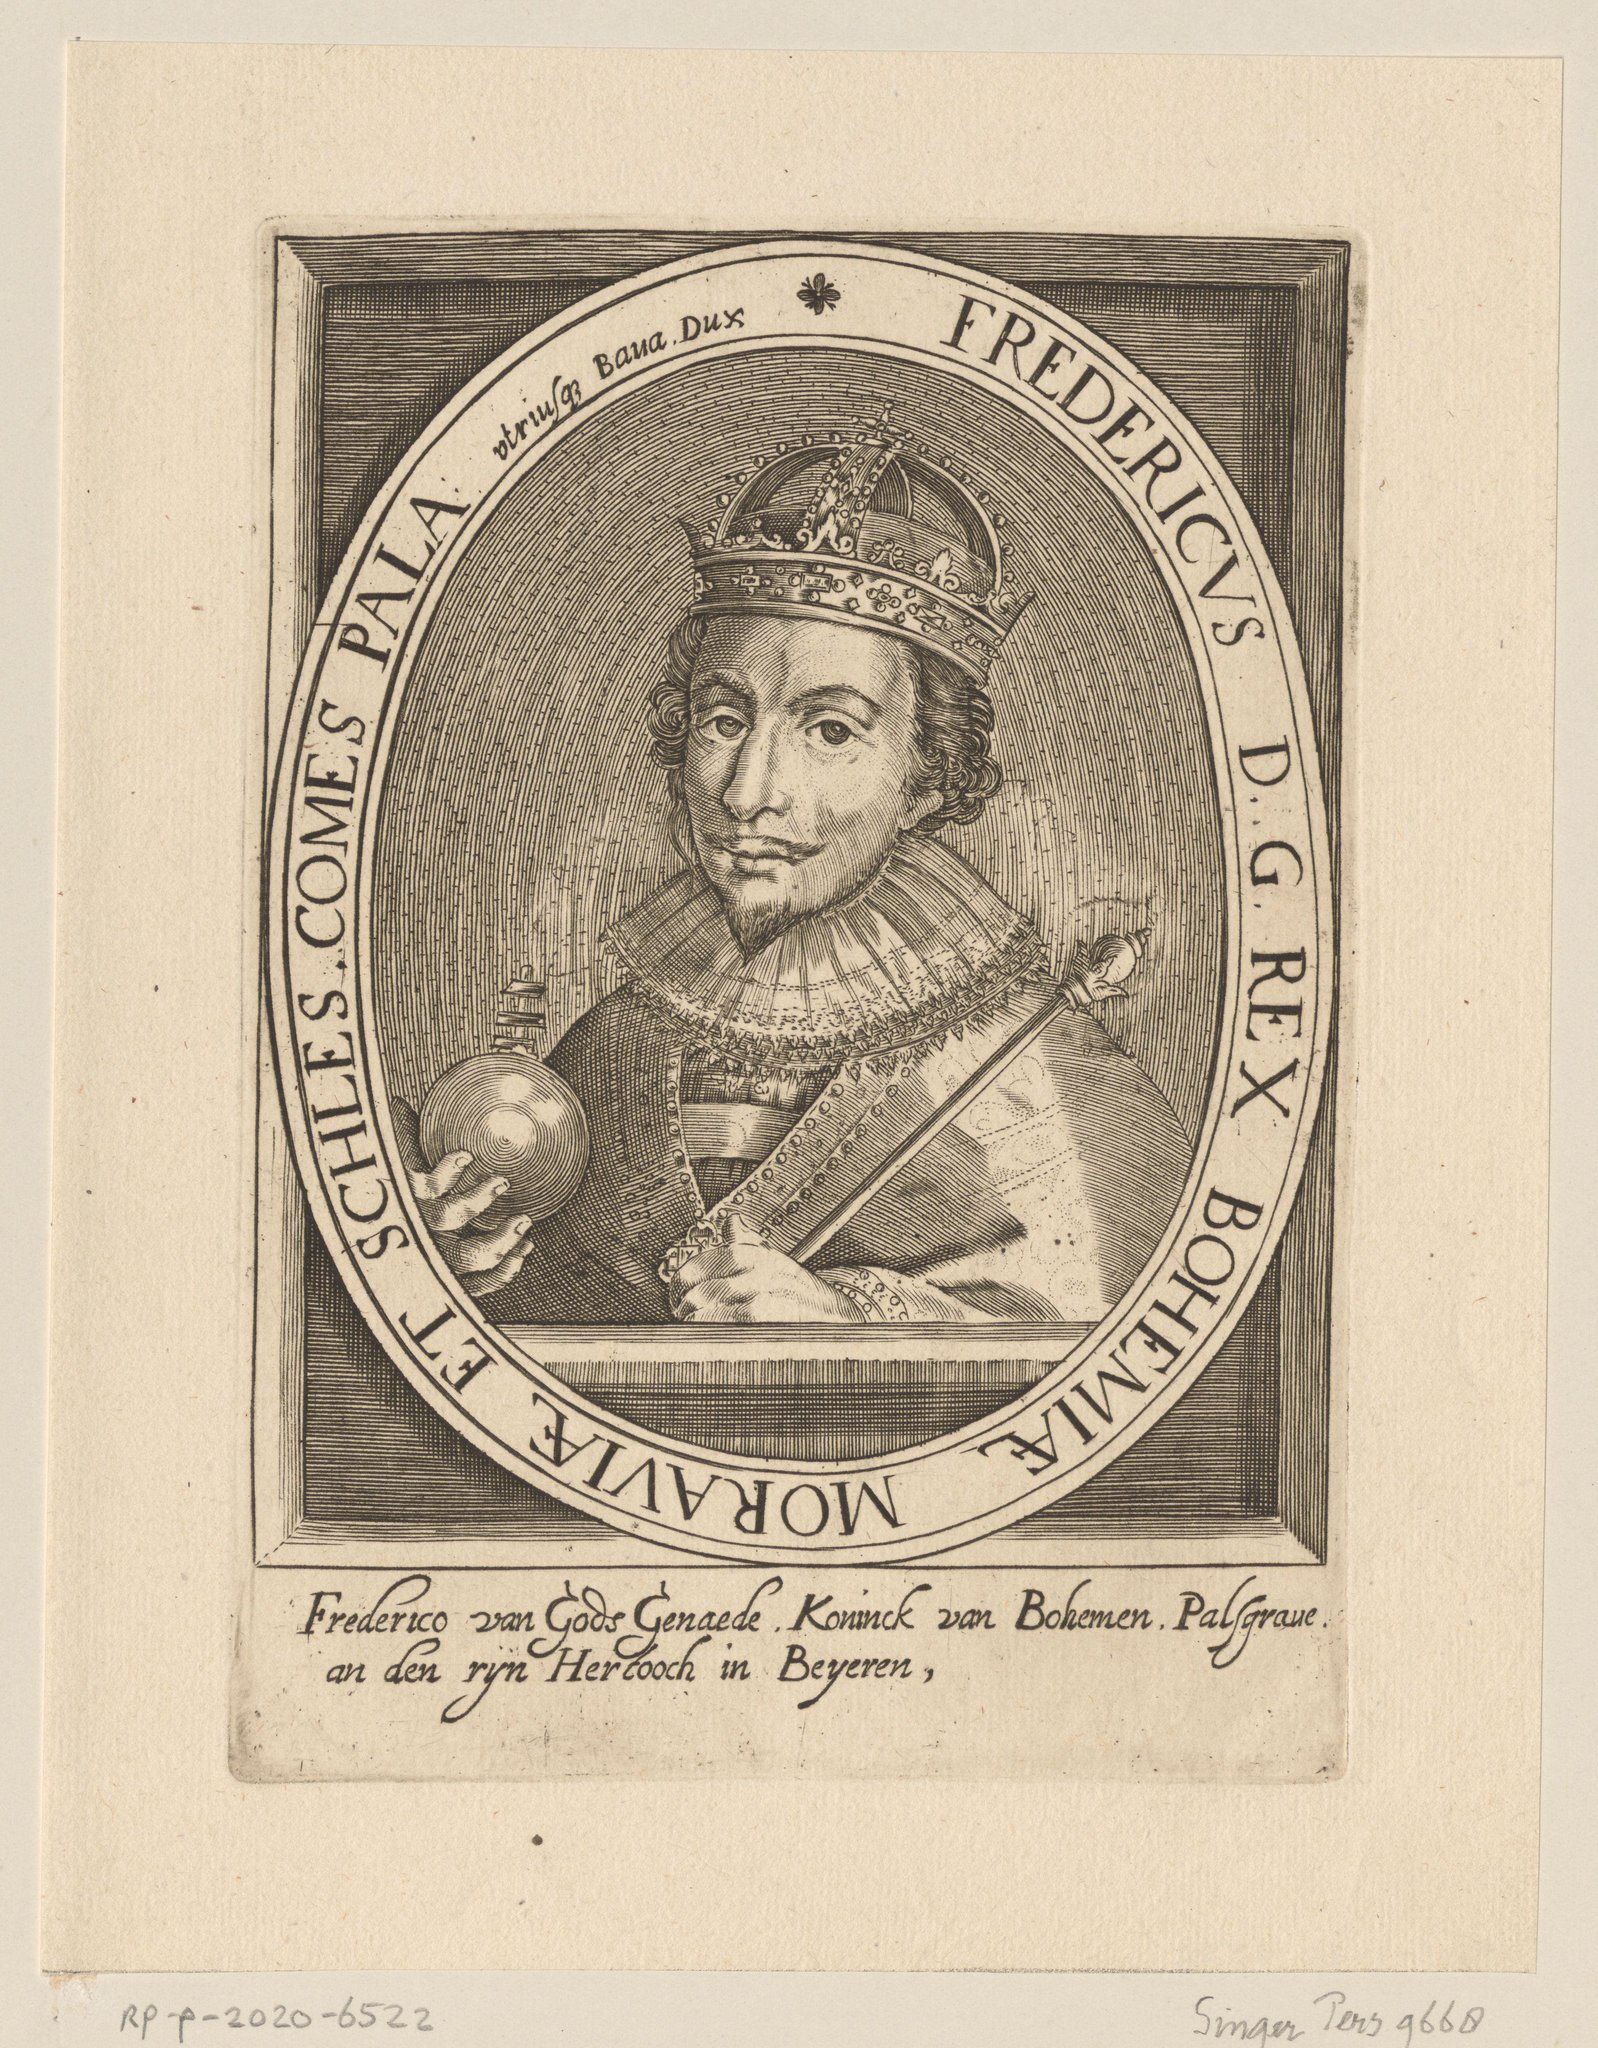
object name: print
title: Portret van Frederik V van de Palts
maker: Anonymous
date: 1619-1650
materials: paper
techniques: engraving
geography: northern netherlands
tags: amberg, frederik v (keurvorst van de palts, koning van bohemen), crown (symbol of sovereignty), orb (symbol of sovereignty; sphere with cross on top), sceptre, staff (symbol of sovereignty), historical persons, king